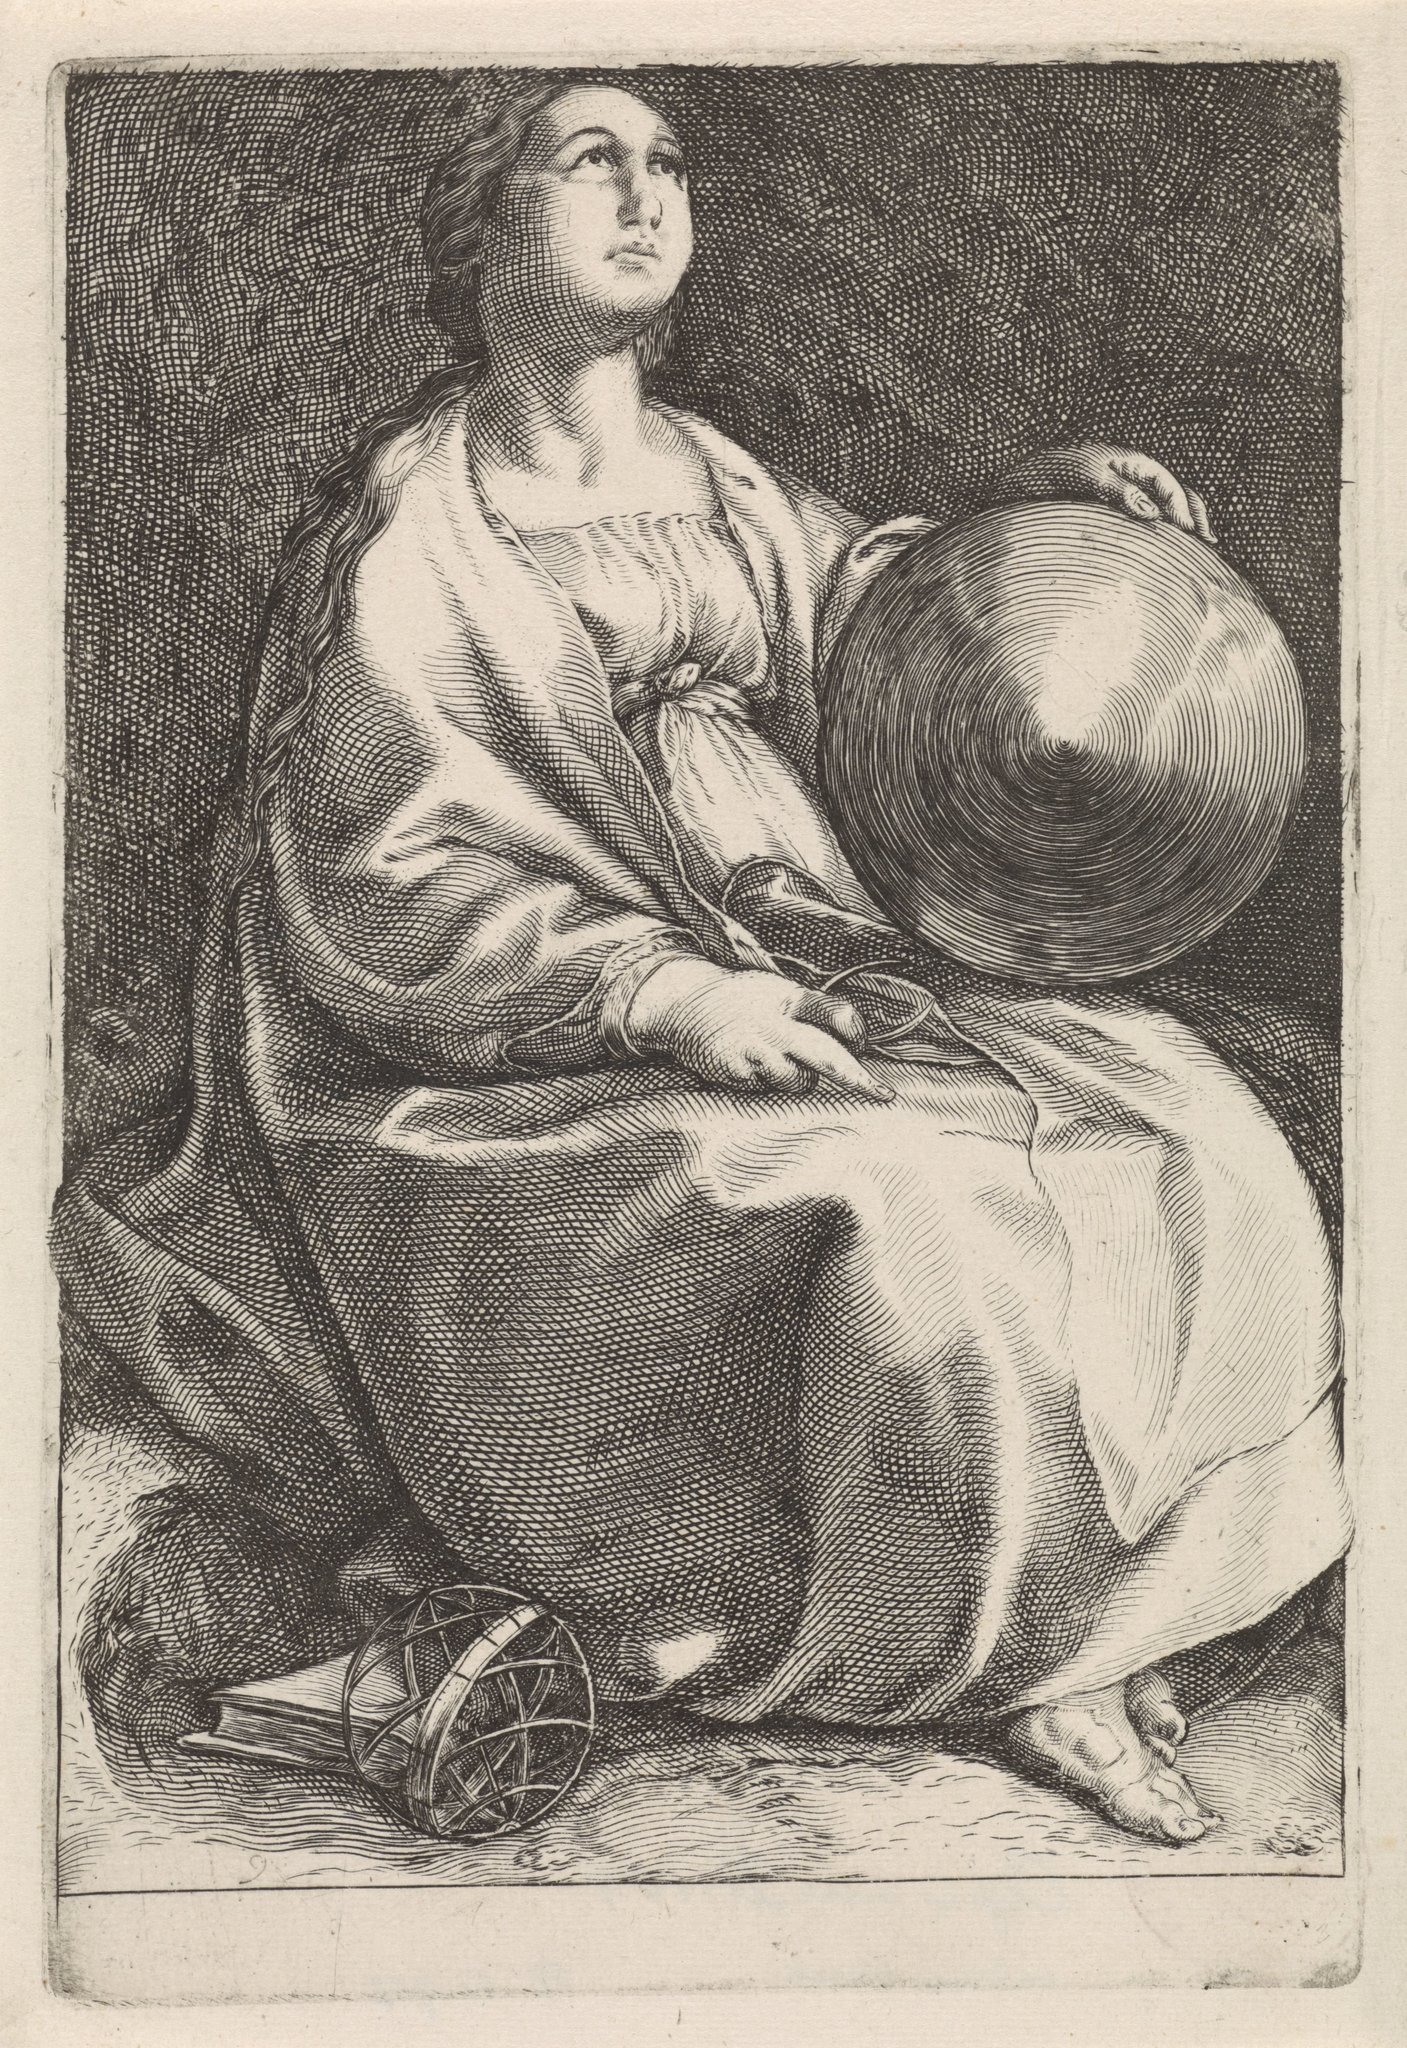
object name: print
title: Urania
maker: Anonymous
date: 1592-1667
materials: paper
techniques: drypoint, engraving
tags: urania (one of the muses); 'urania' (ripa)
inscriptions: collector's mark: Lugt 240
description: De zittende Urania, de muze van de astronomie, houdt een globe in haar hand. Naast haar liggen een armillarium en een boek.